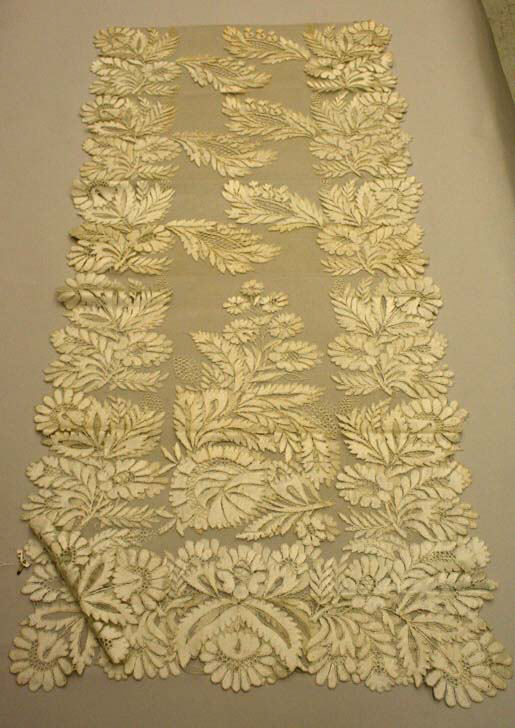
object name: scarf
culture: spanish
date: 1801-1900